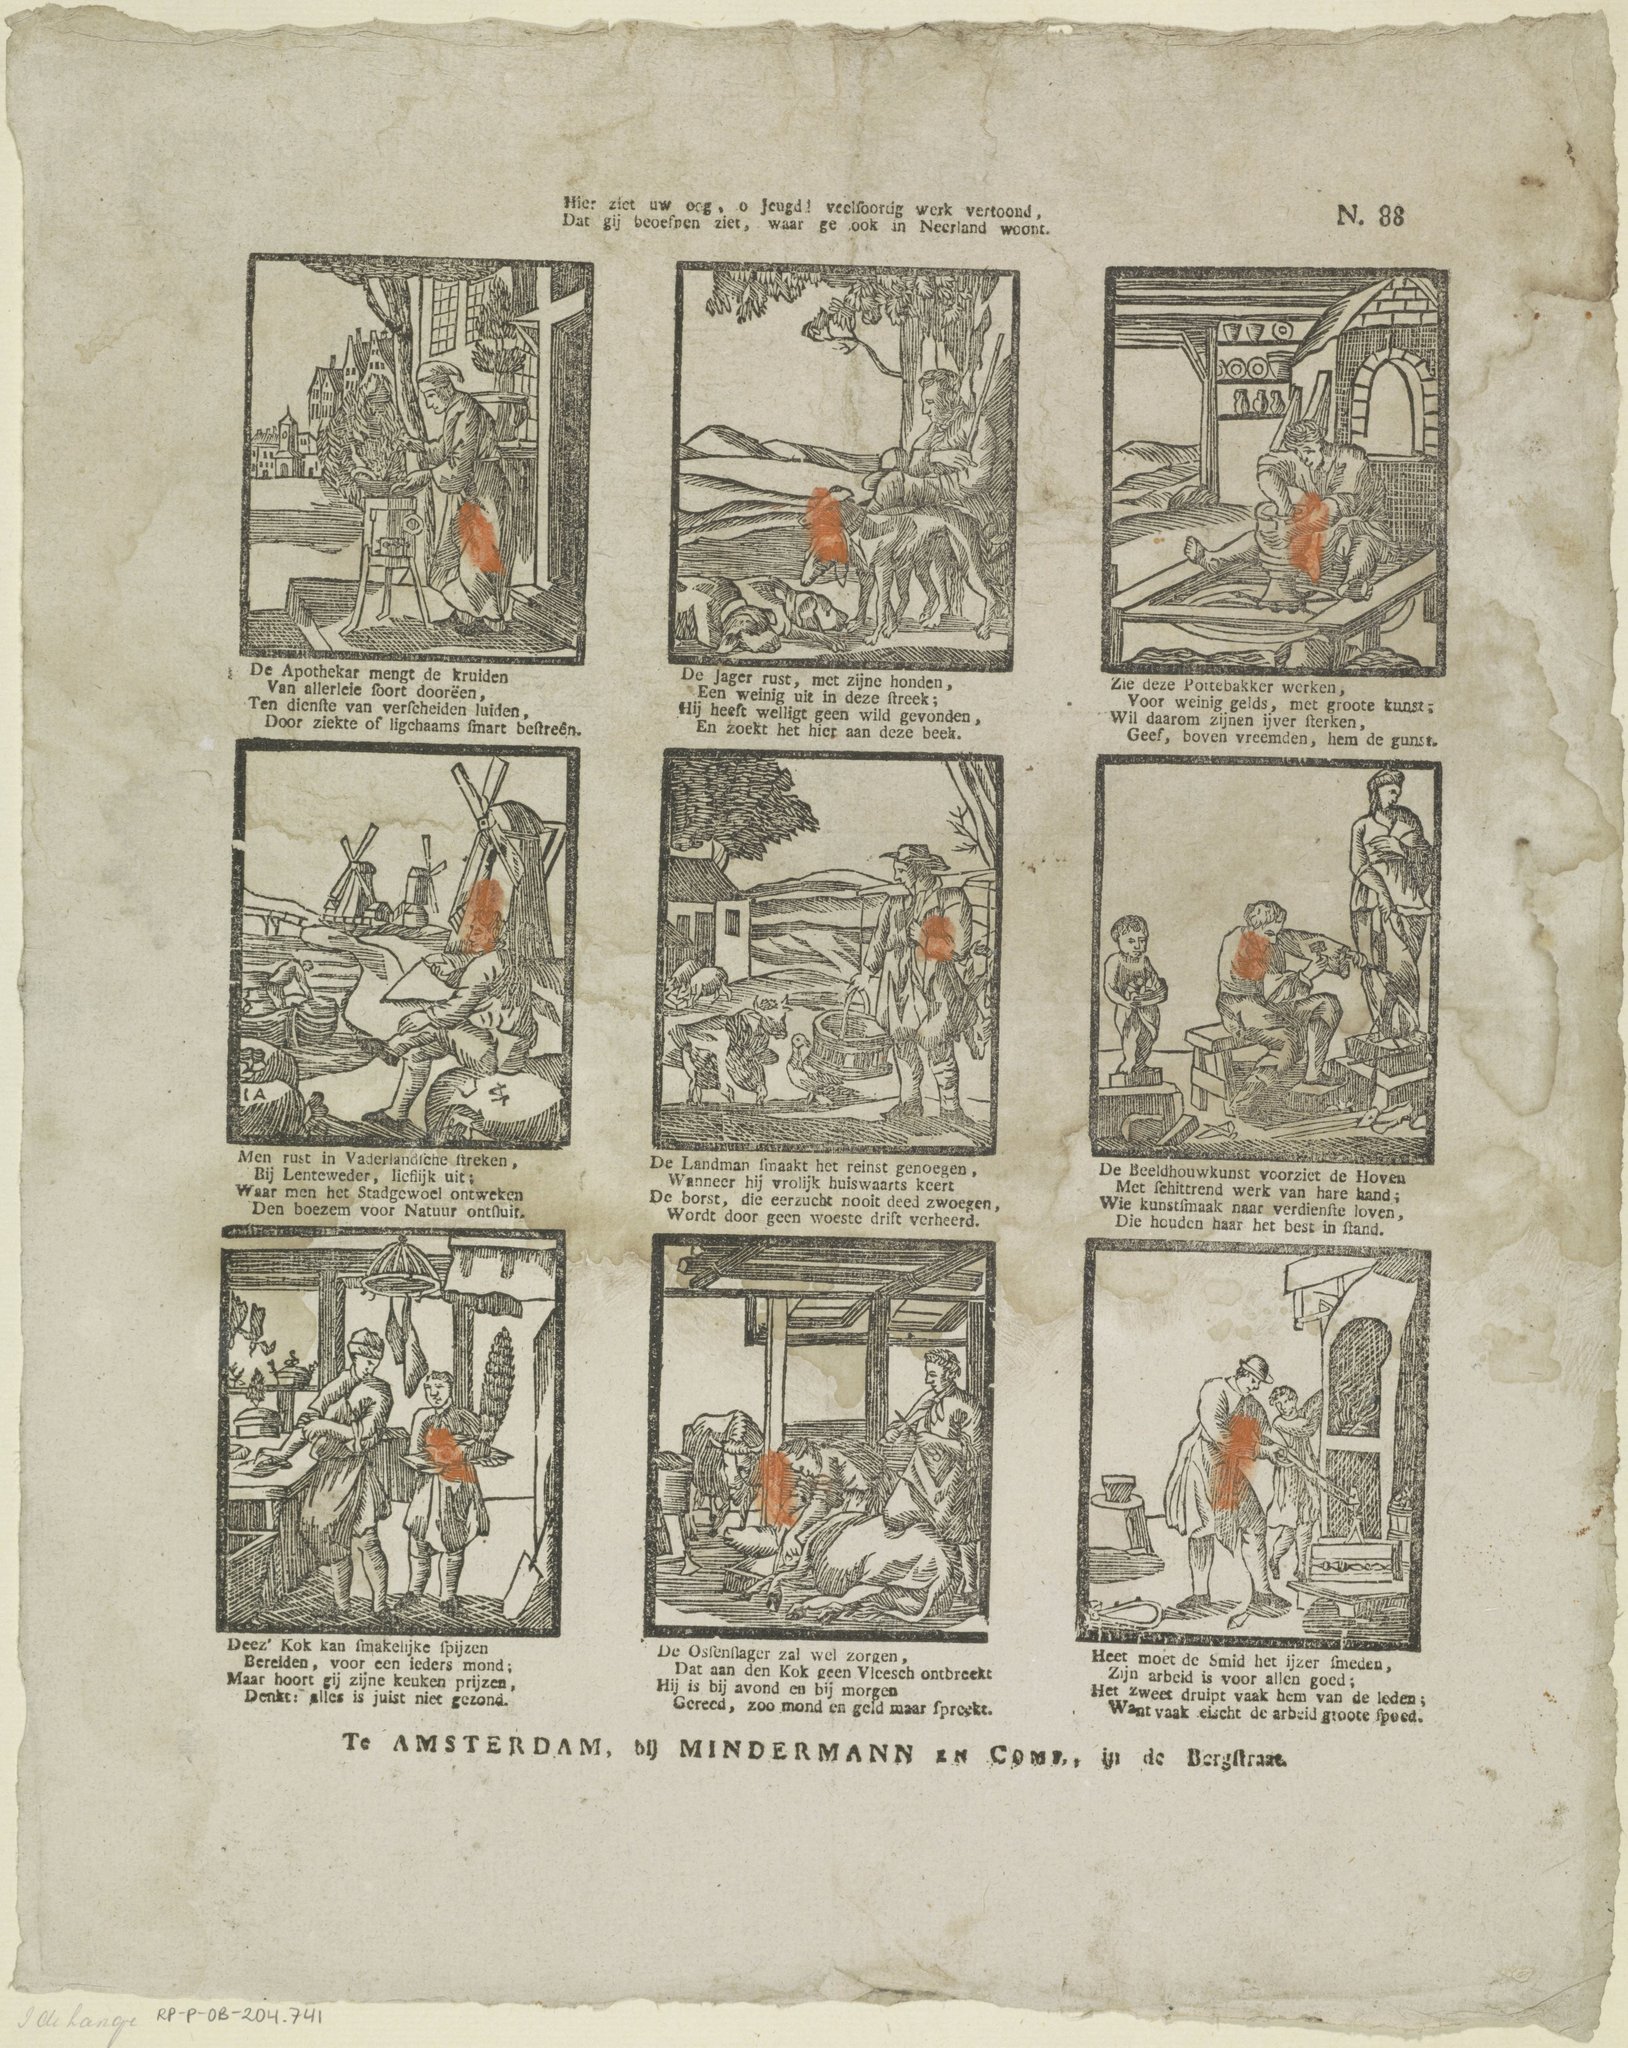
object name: print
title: Hier ziet uw oog, o jeugd! veelsoortig werk vertoond, / Dat gij beoefnen ziet, waar ge ook in Neerland woont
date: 1822-1849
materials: paper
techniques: colour, letterpress printing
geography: amsterdam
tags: craft-production, skilled handiwork, pharmacist, druggist, apothecary; pharmacy, drugstore, dispensing chemist, hunter, butcher, slaughterman, crafts and industries, potter, ceramist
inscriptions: collector's mark: Lugt 2760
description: Blad met 9 voorstellingen van ambachtslieden en beroepen, zoals apotheker, jager en slager. Onder elke afbeelding een vierregelig vers. Genummerd rechtsboven: N. 88.